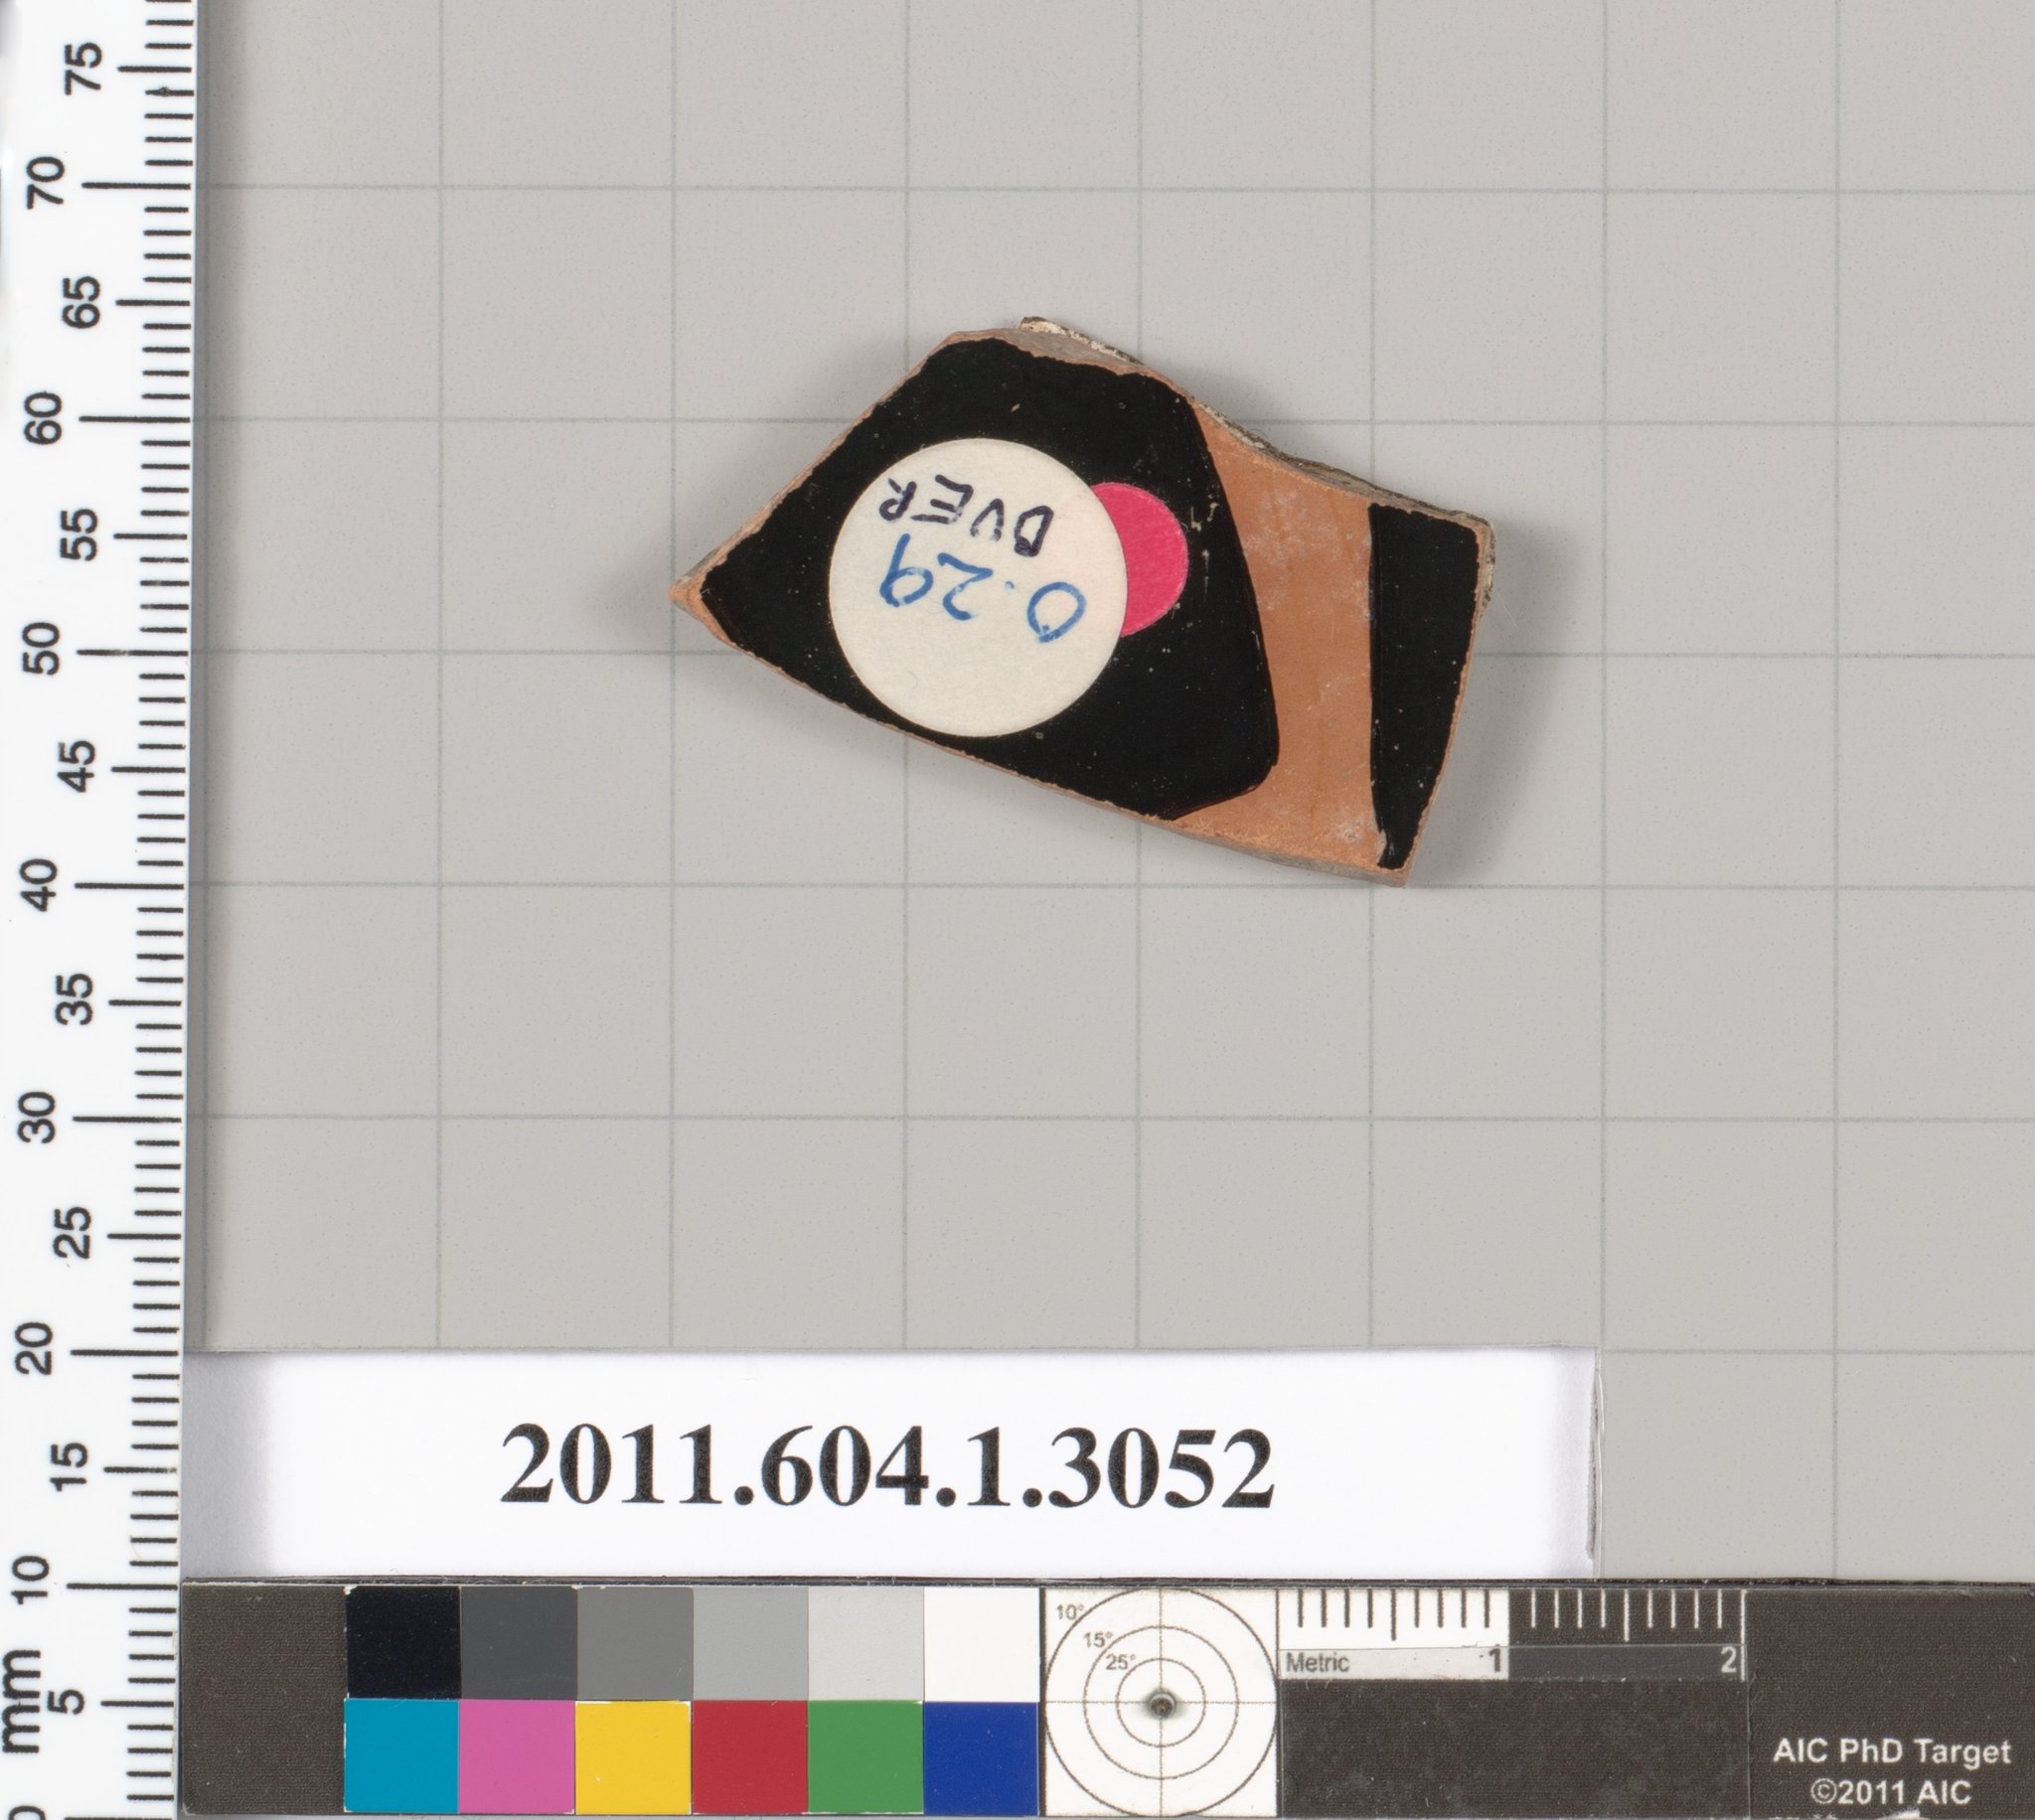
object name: kylix fragment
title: Terracotta fragment of a kylix (drinking cup)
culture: greek, attic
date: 500-480 BCE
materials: terracotta